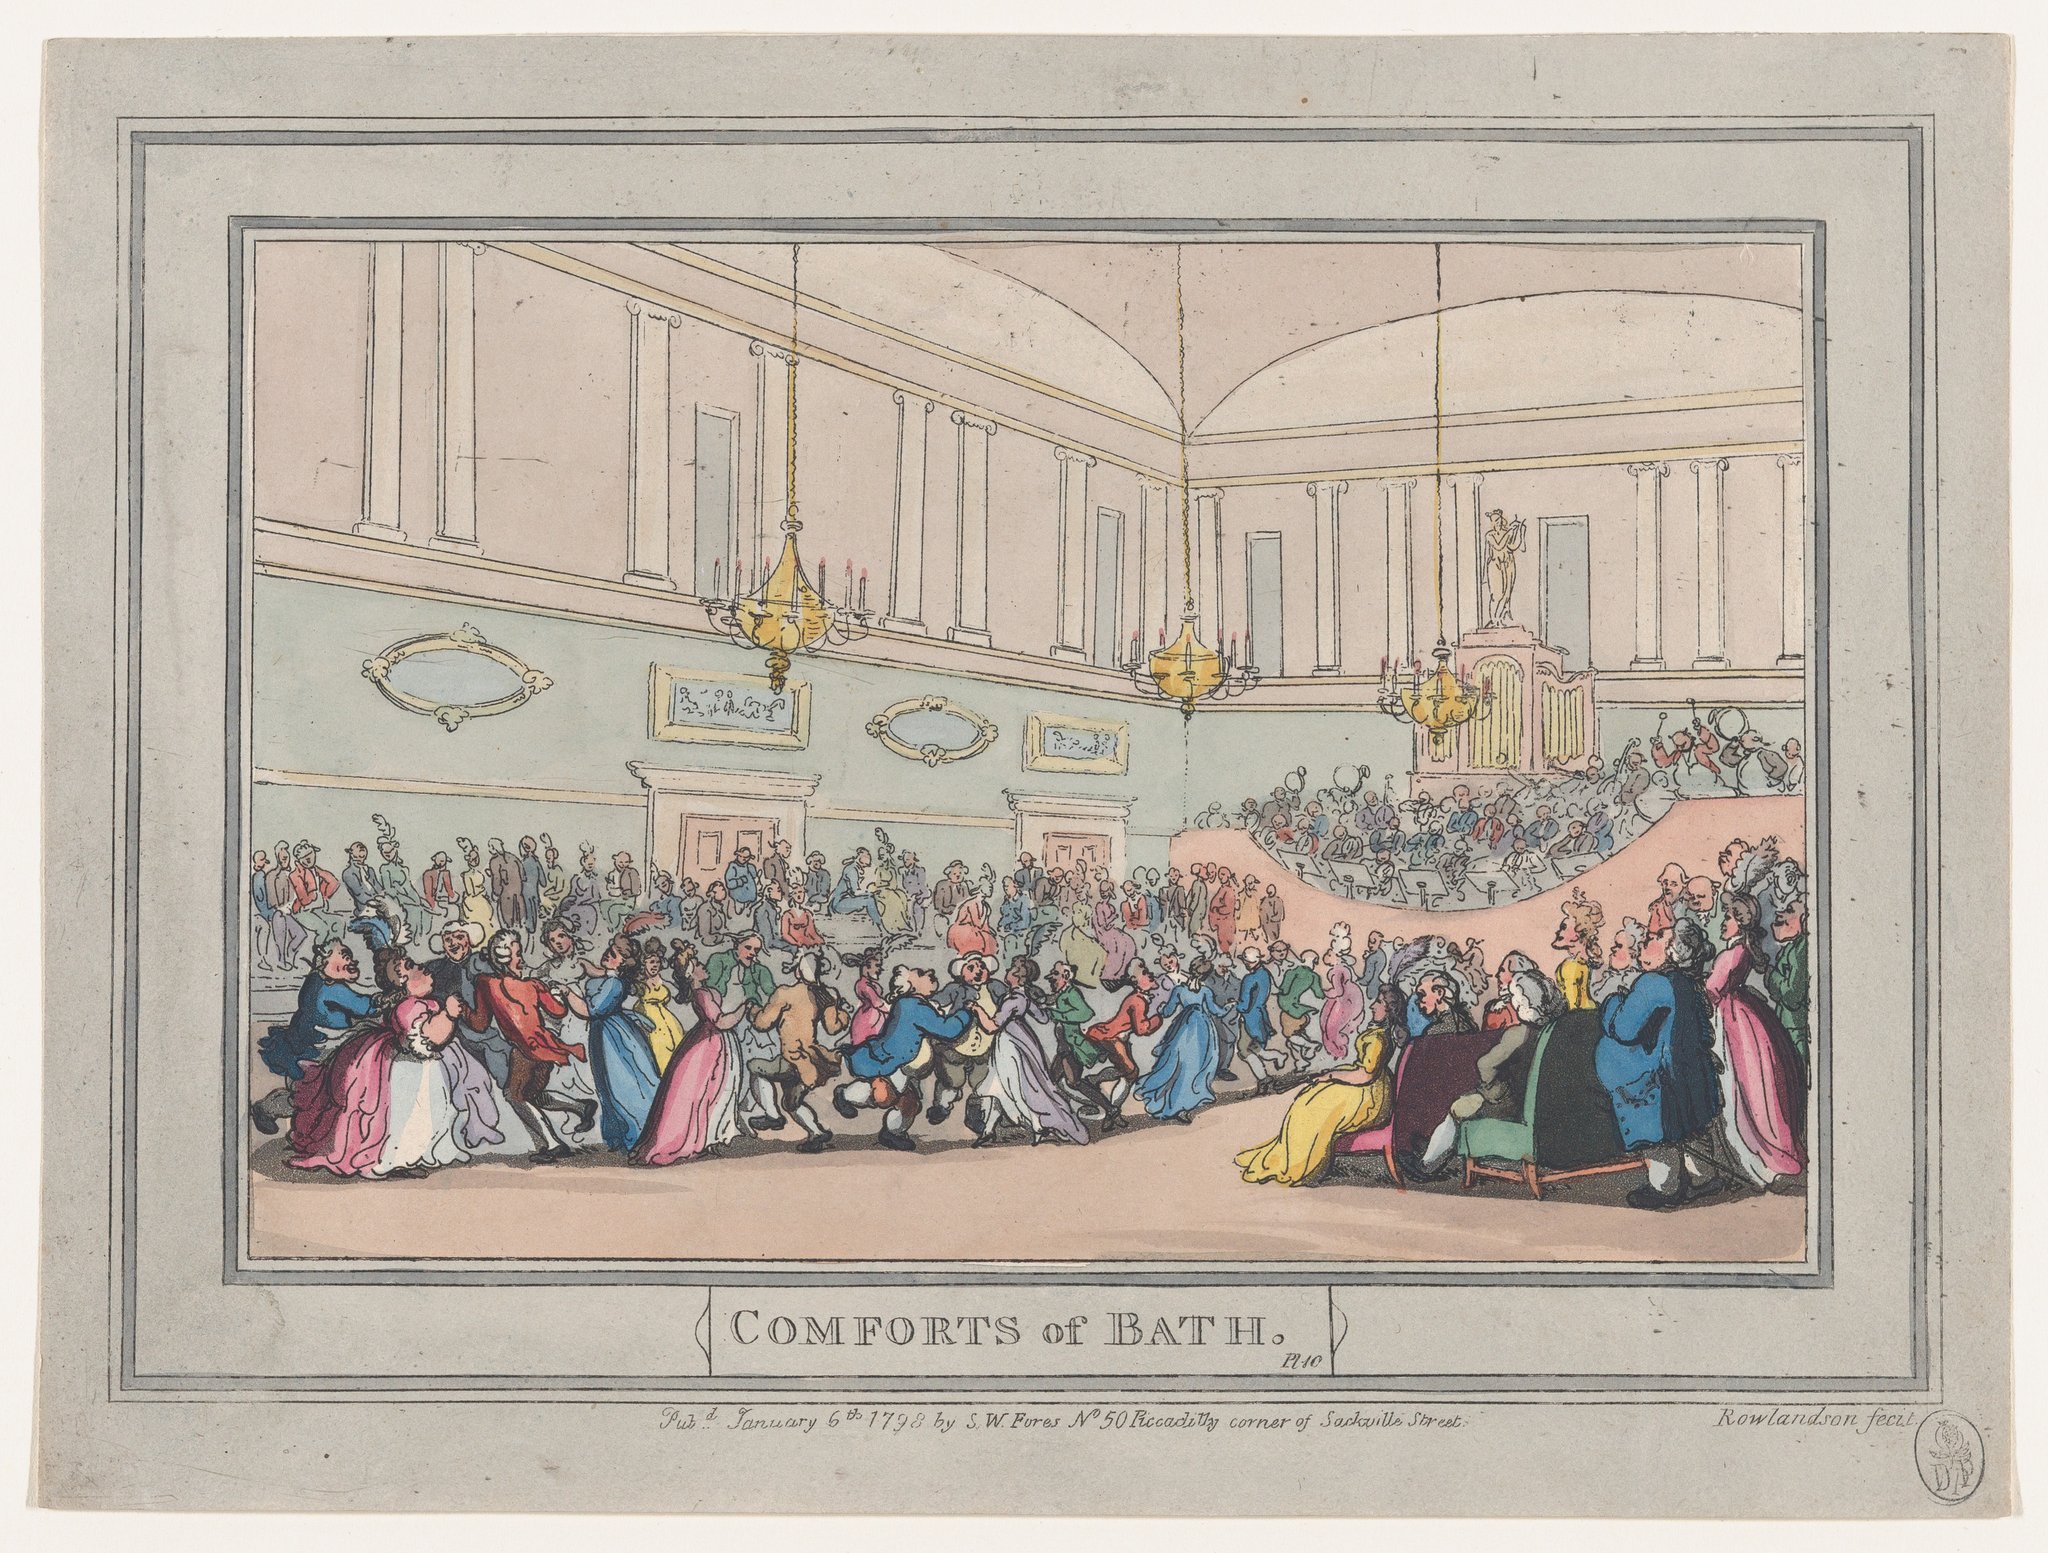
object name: print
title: Comforts of Bath, Plate 10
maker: thomas rowlandson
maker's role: artist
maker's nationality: british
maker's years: 1757-1827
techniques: aquatint, etching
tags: men,women,dancing,crowd